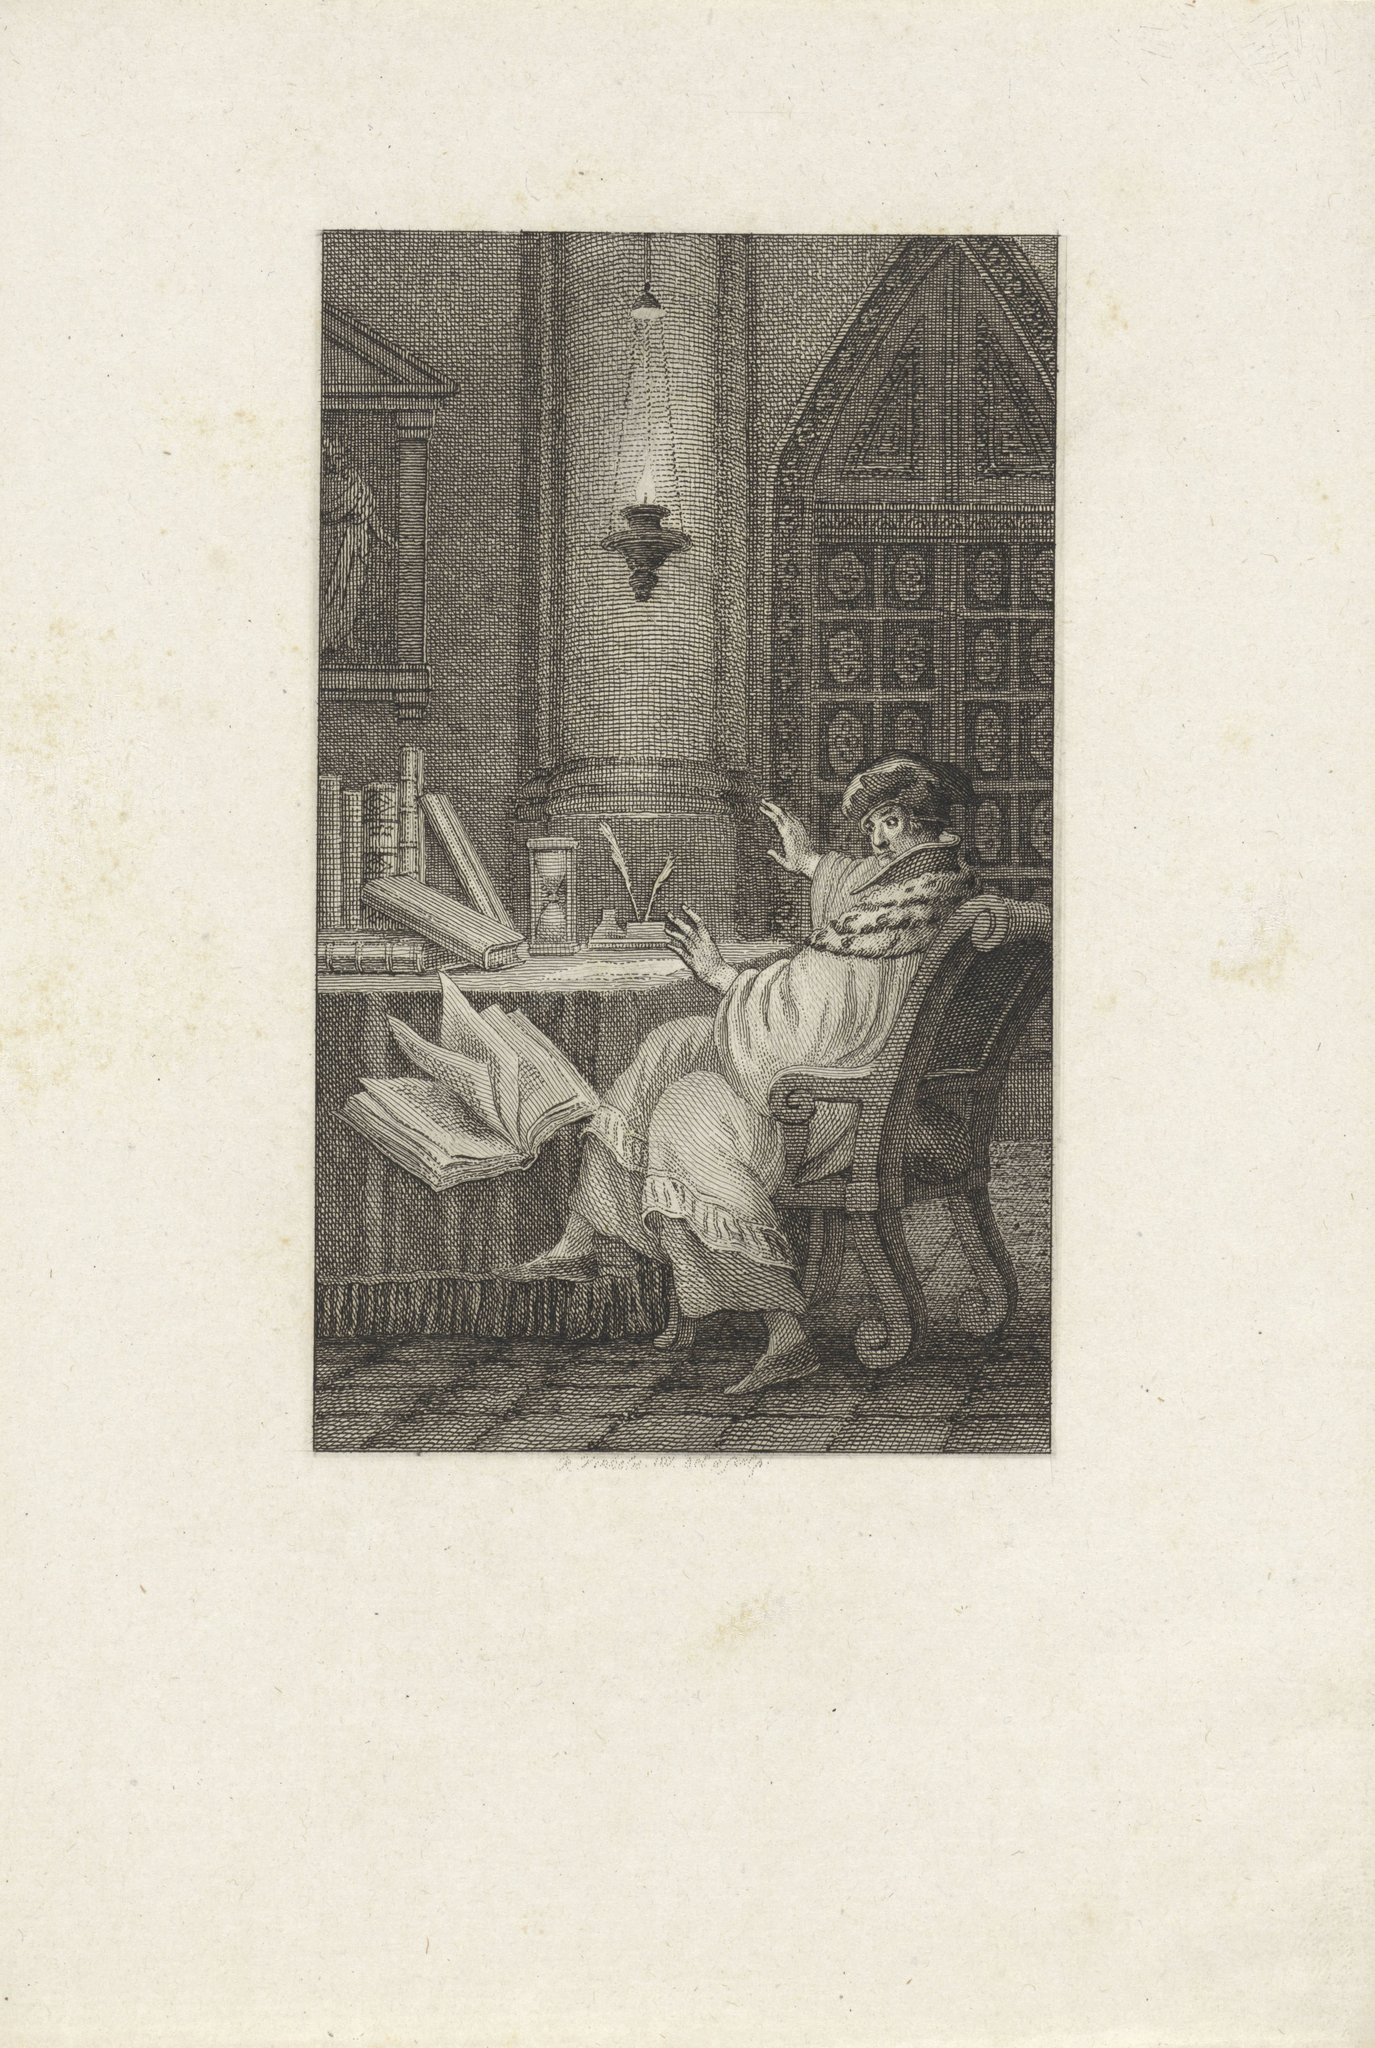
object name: print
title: Thomas Linacre gooit het Nieuwe Testament vol verbazing op de grond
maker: reinier vinkeles (i)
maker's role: draughtsman, print maker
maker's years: 1741-1816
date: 1807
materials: paper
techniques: engraving, etching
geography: amsterdam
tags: writing tools, book, new testament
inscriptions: collector's mark: Lugt 2228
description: Proefdruk van een illustratie in: Hamelsveld, Ysbrand van. Algemeene kerkelijke geschiedenis, der Christenen, deel 15. Haarlem: François Bohn, 1807, p. 198.